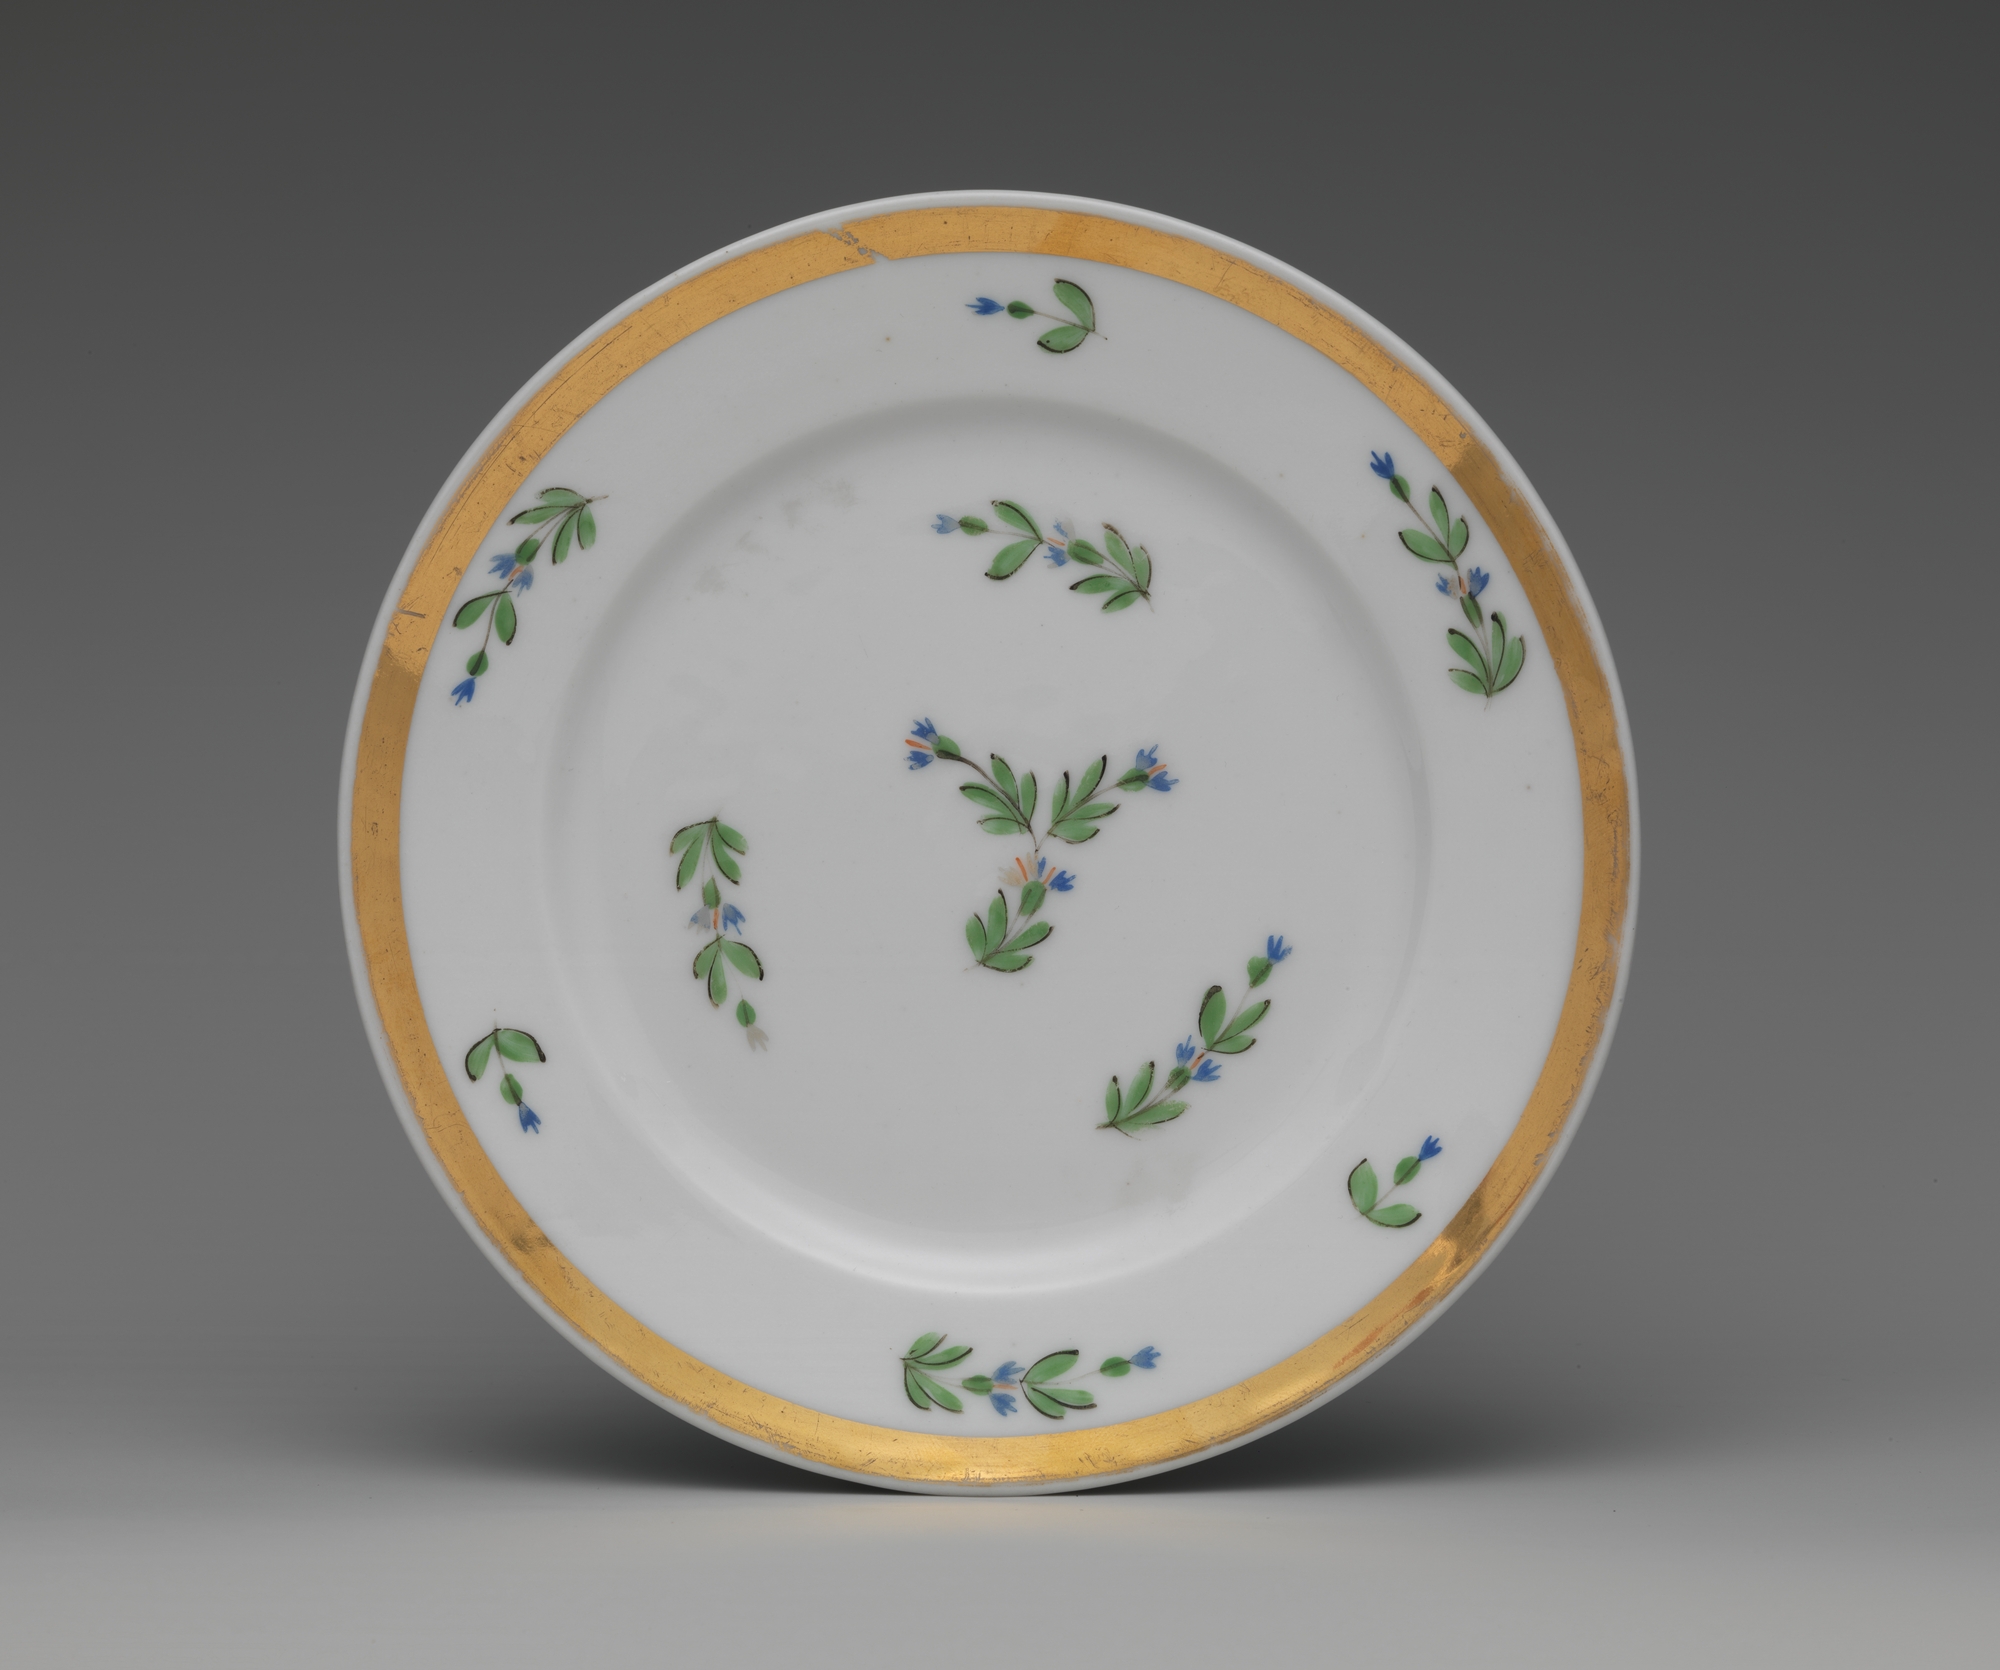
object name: plate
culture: french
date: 1815-1830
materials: porcelain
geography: france